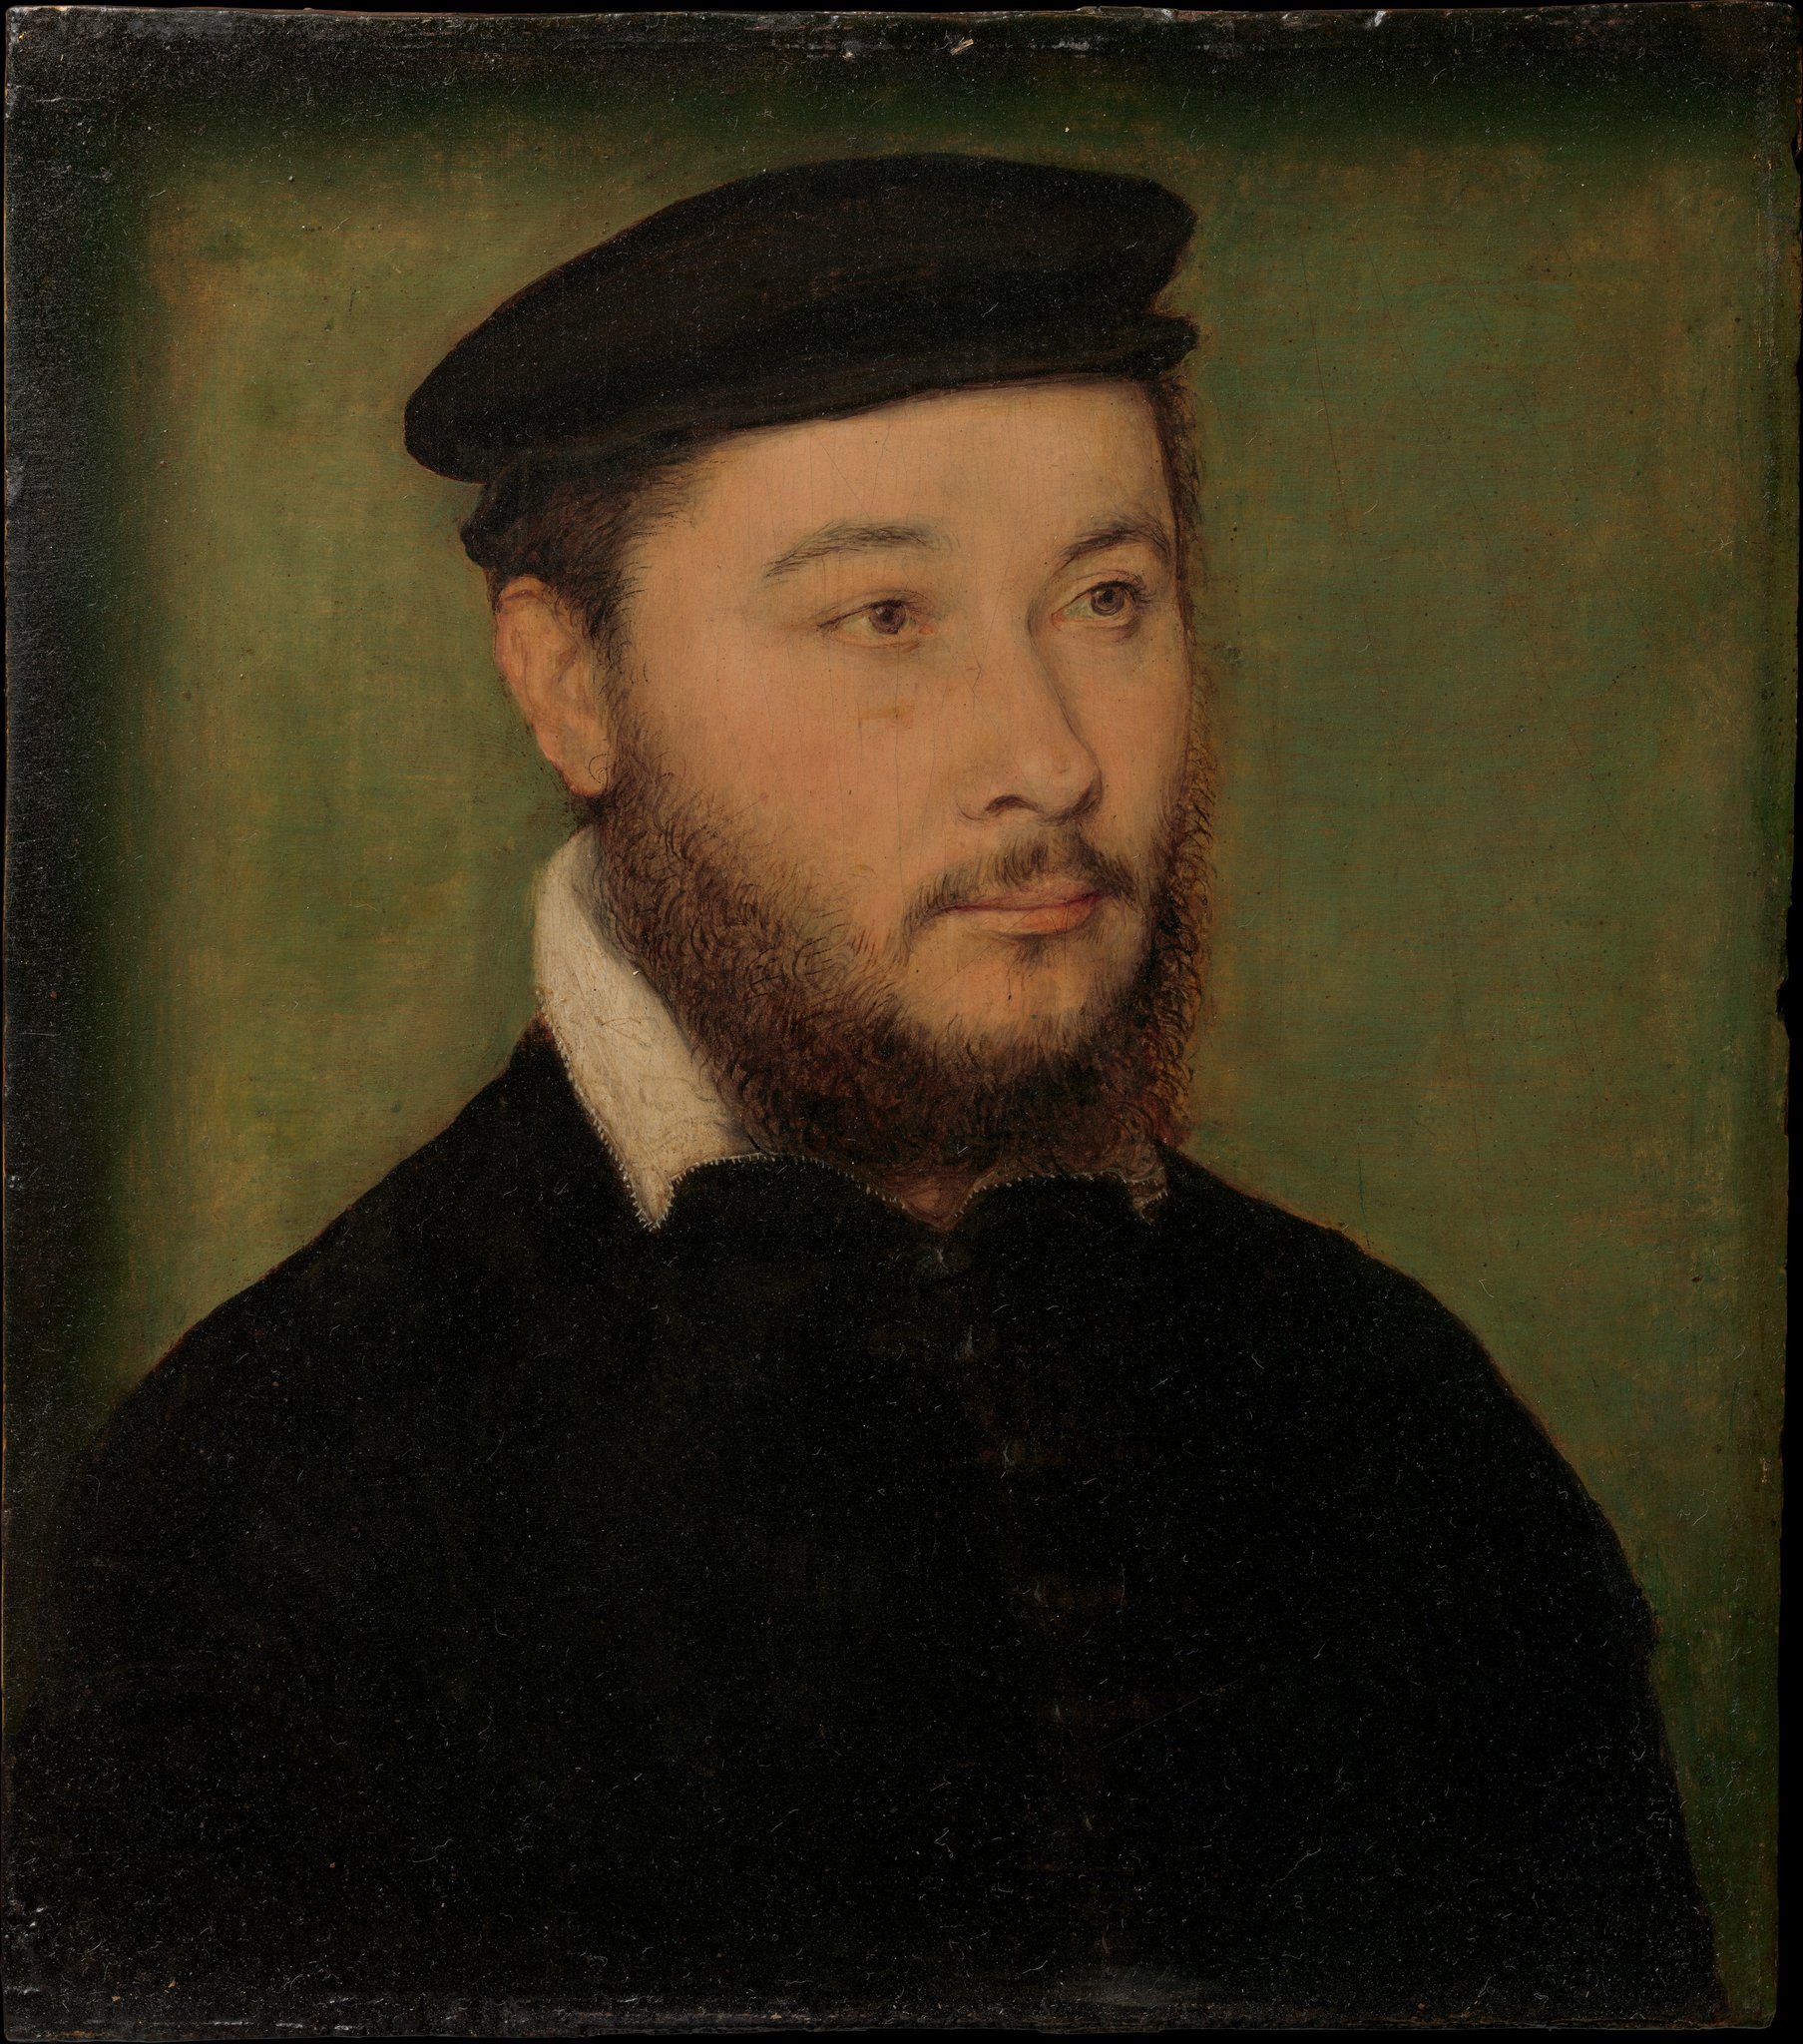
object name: painting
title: Portrait of a Man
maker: corneille de lyon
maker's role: artist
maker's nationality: netherlandish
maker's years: 1533-1575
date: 1540-1550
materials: oil, wood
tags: men,portraits